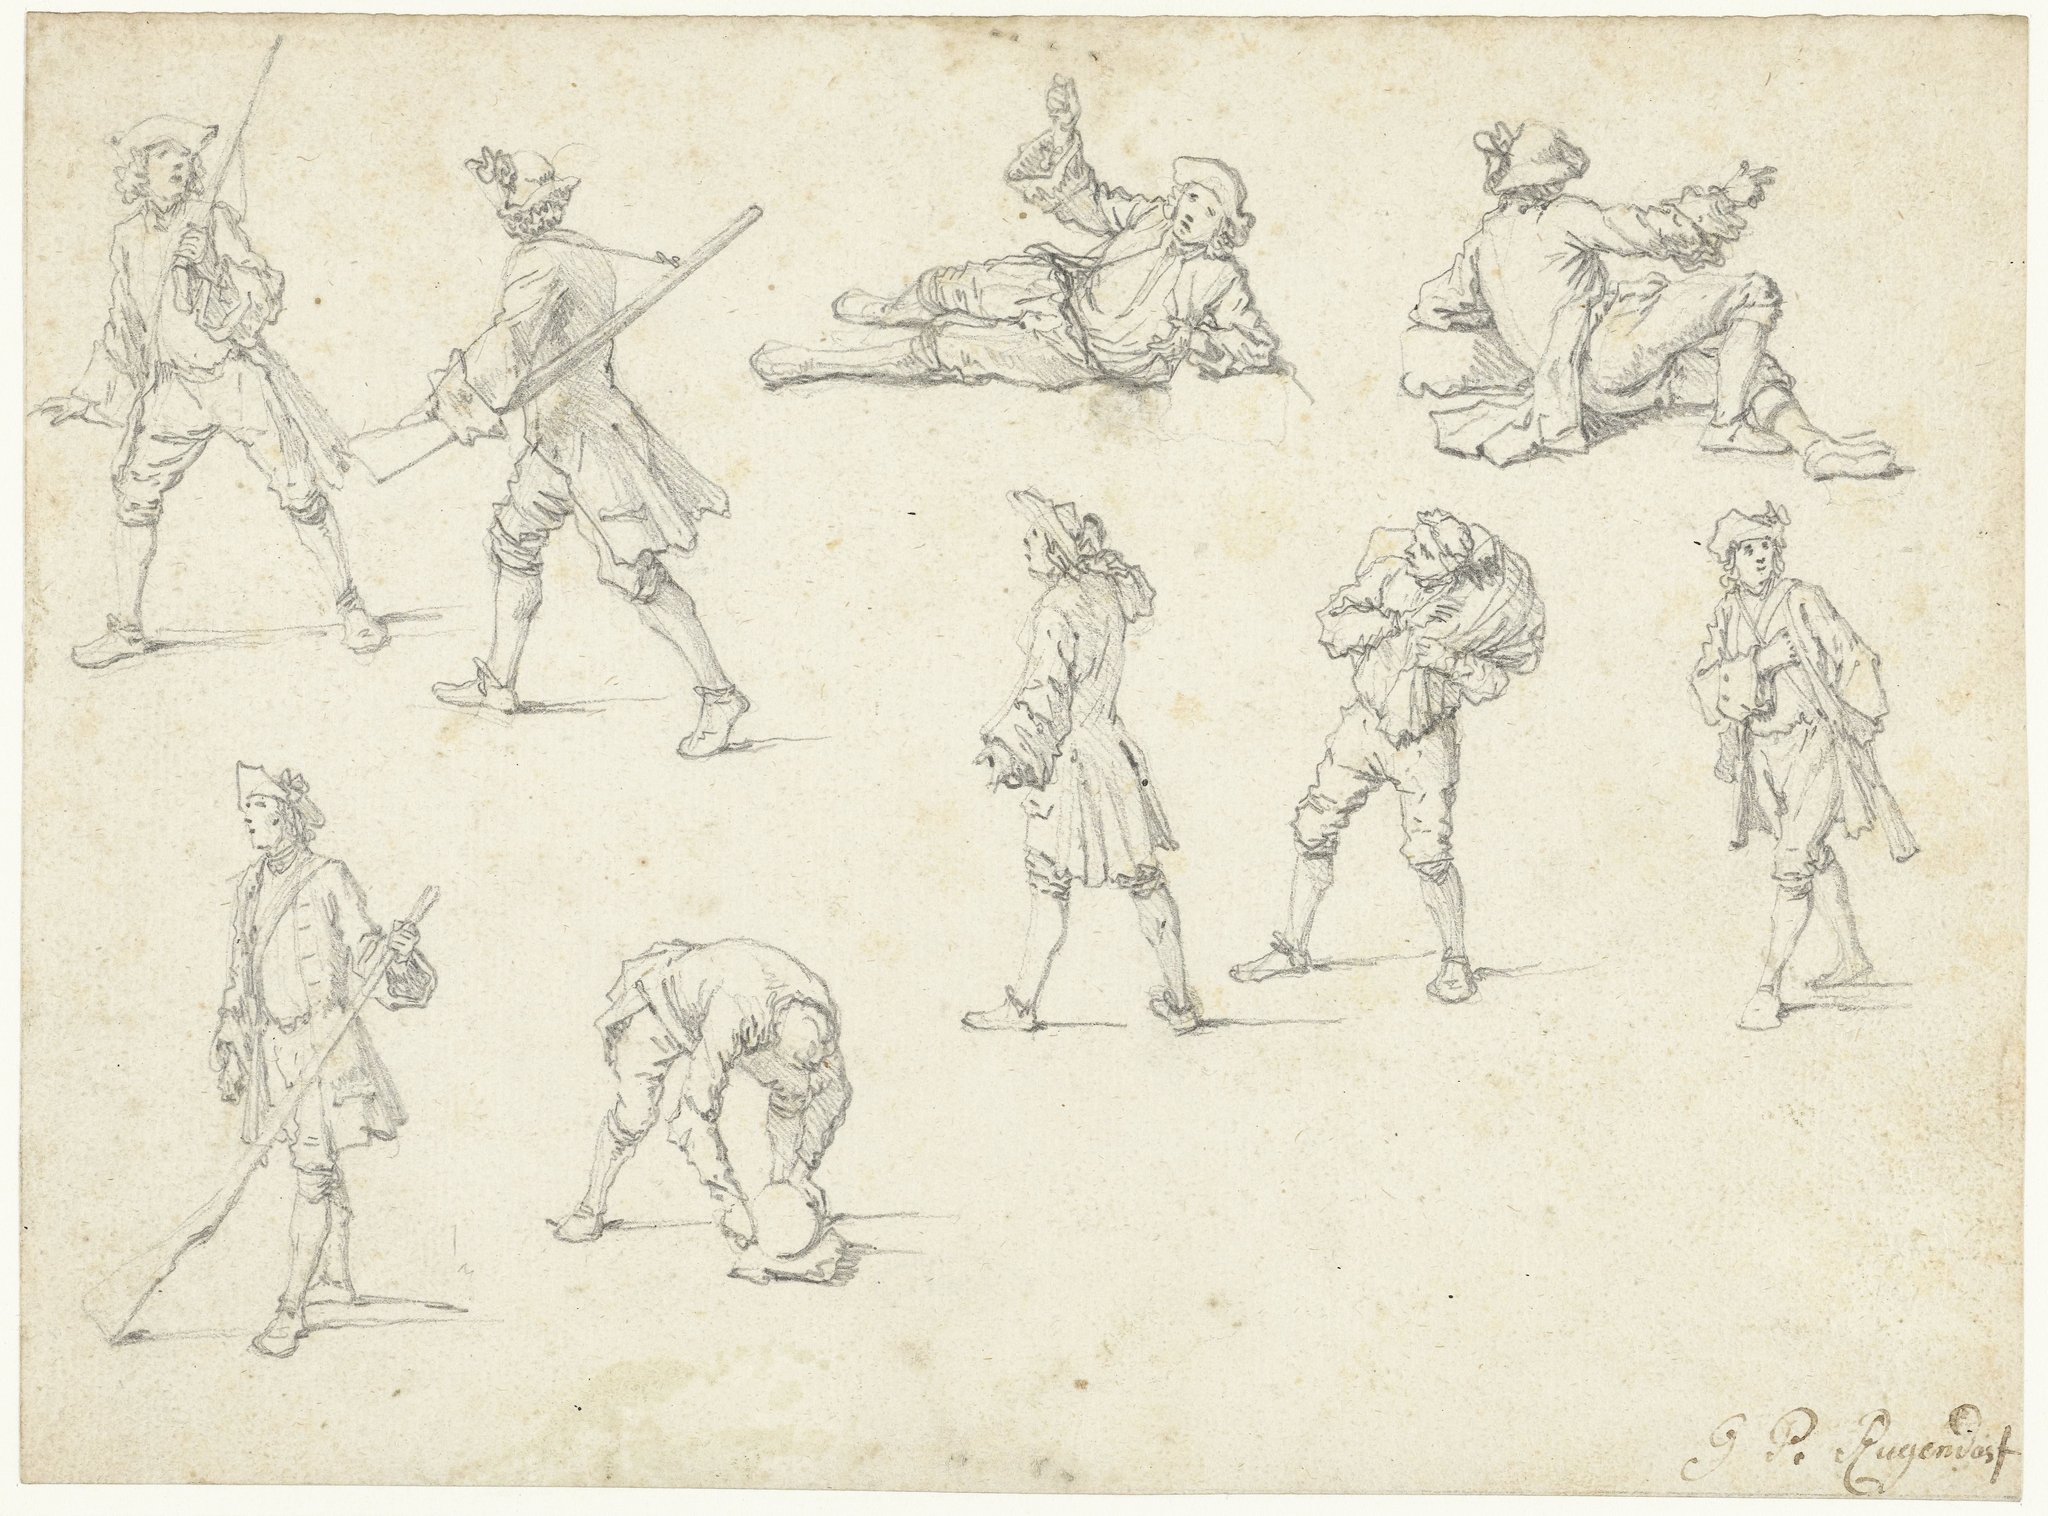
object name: drawing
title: Studieblad met negen figuren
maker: georg philipp rugendas (i)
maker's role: draughtsman, print maker, publisher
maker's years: 1666-1742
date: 1676-1742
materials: paper, pencil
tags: hunter